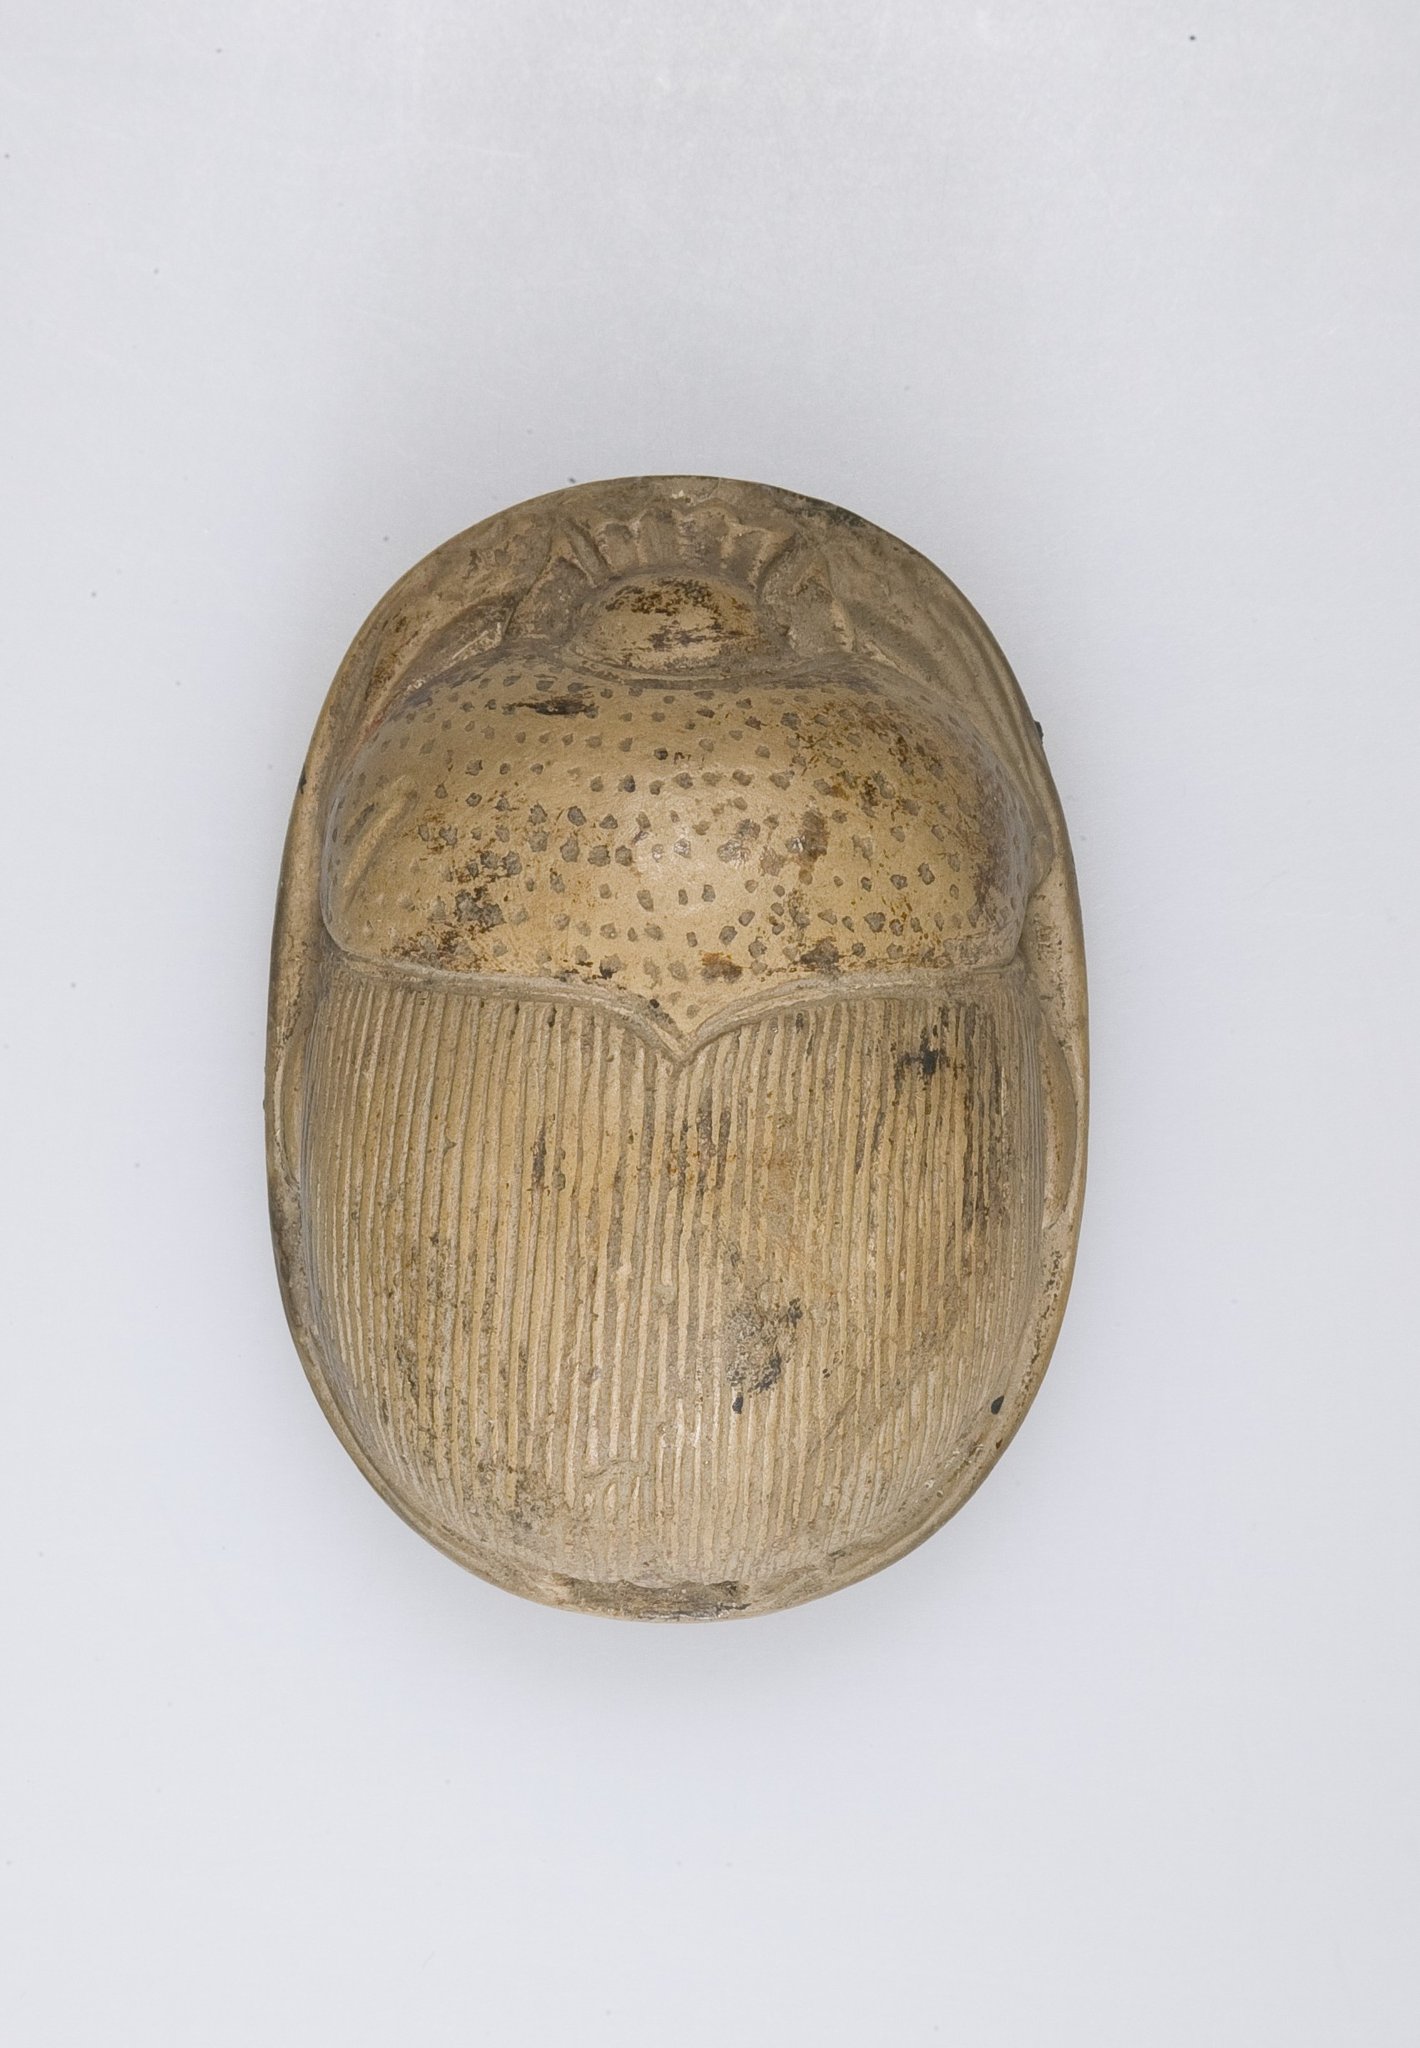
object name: heart scarab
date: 1295-1070 BCE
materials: limestone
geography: egypt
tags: hieroglyphs,scarabs